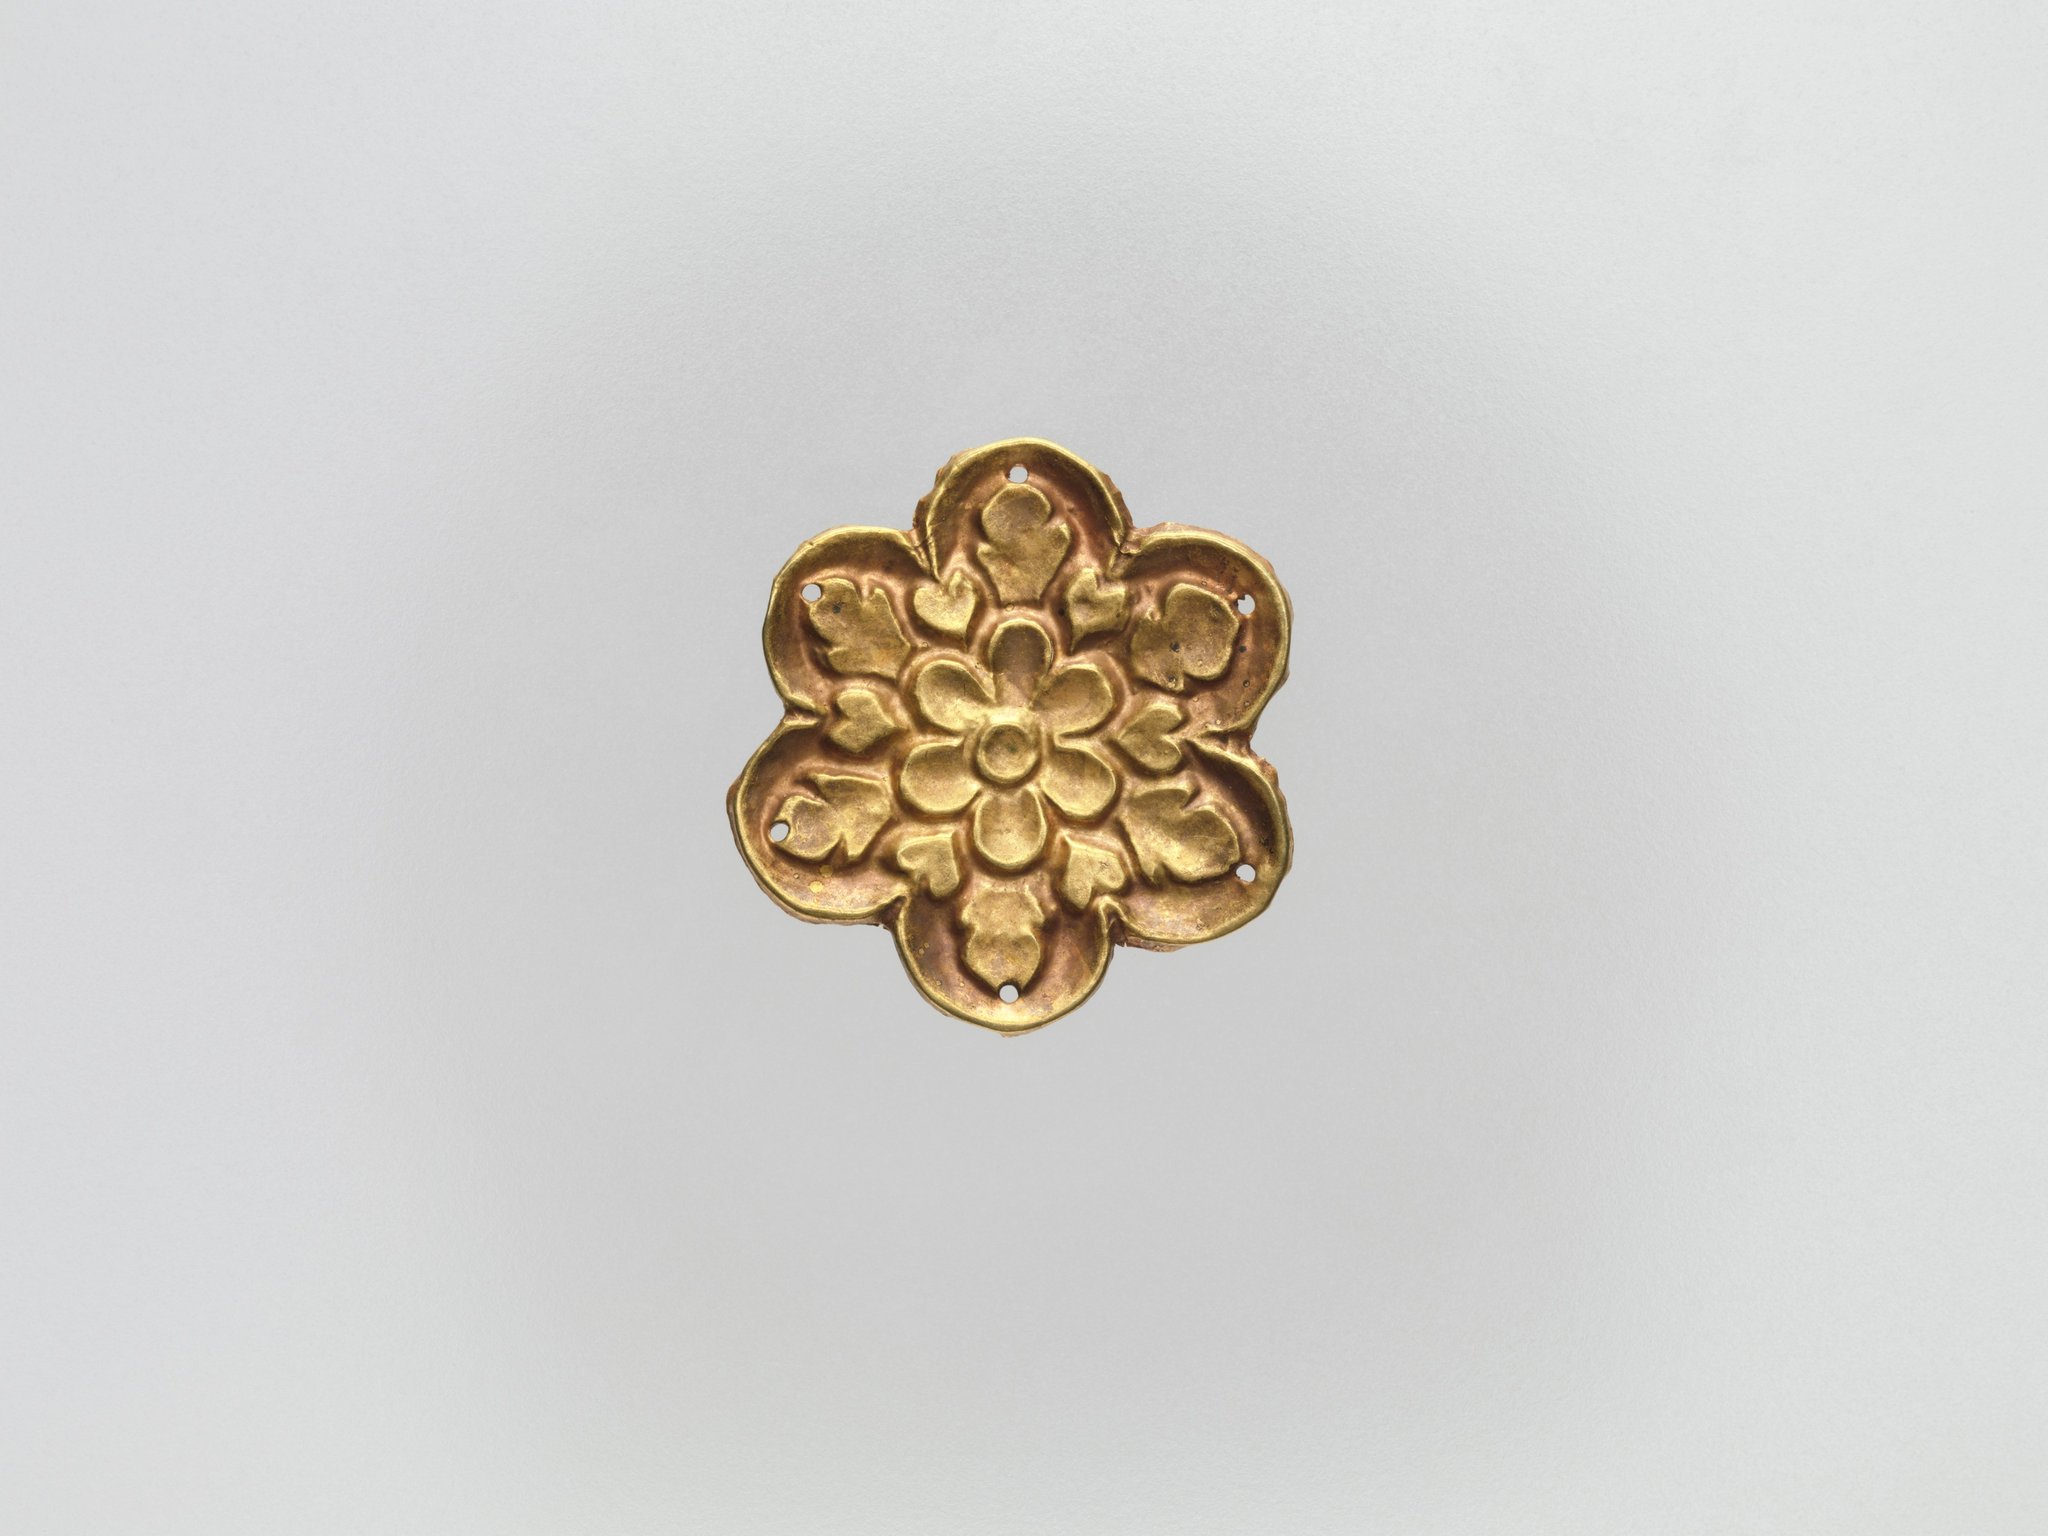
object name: garment plaque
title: Flower-Shaped Clothing Plaque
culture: chinese or central asian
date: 601-900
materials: gold